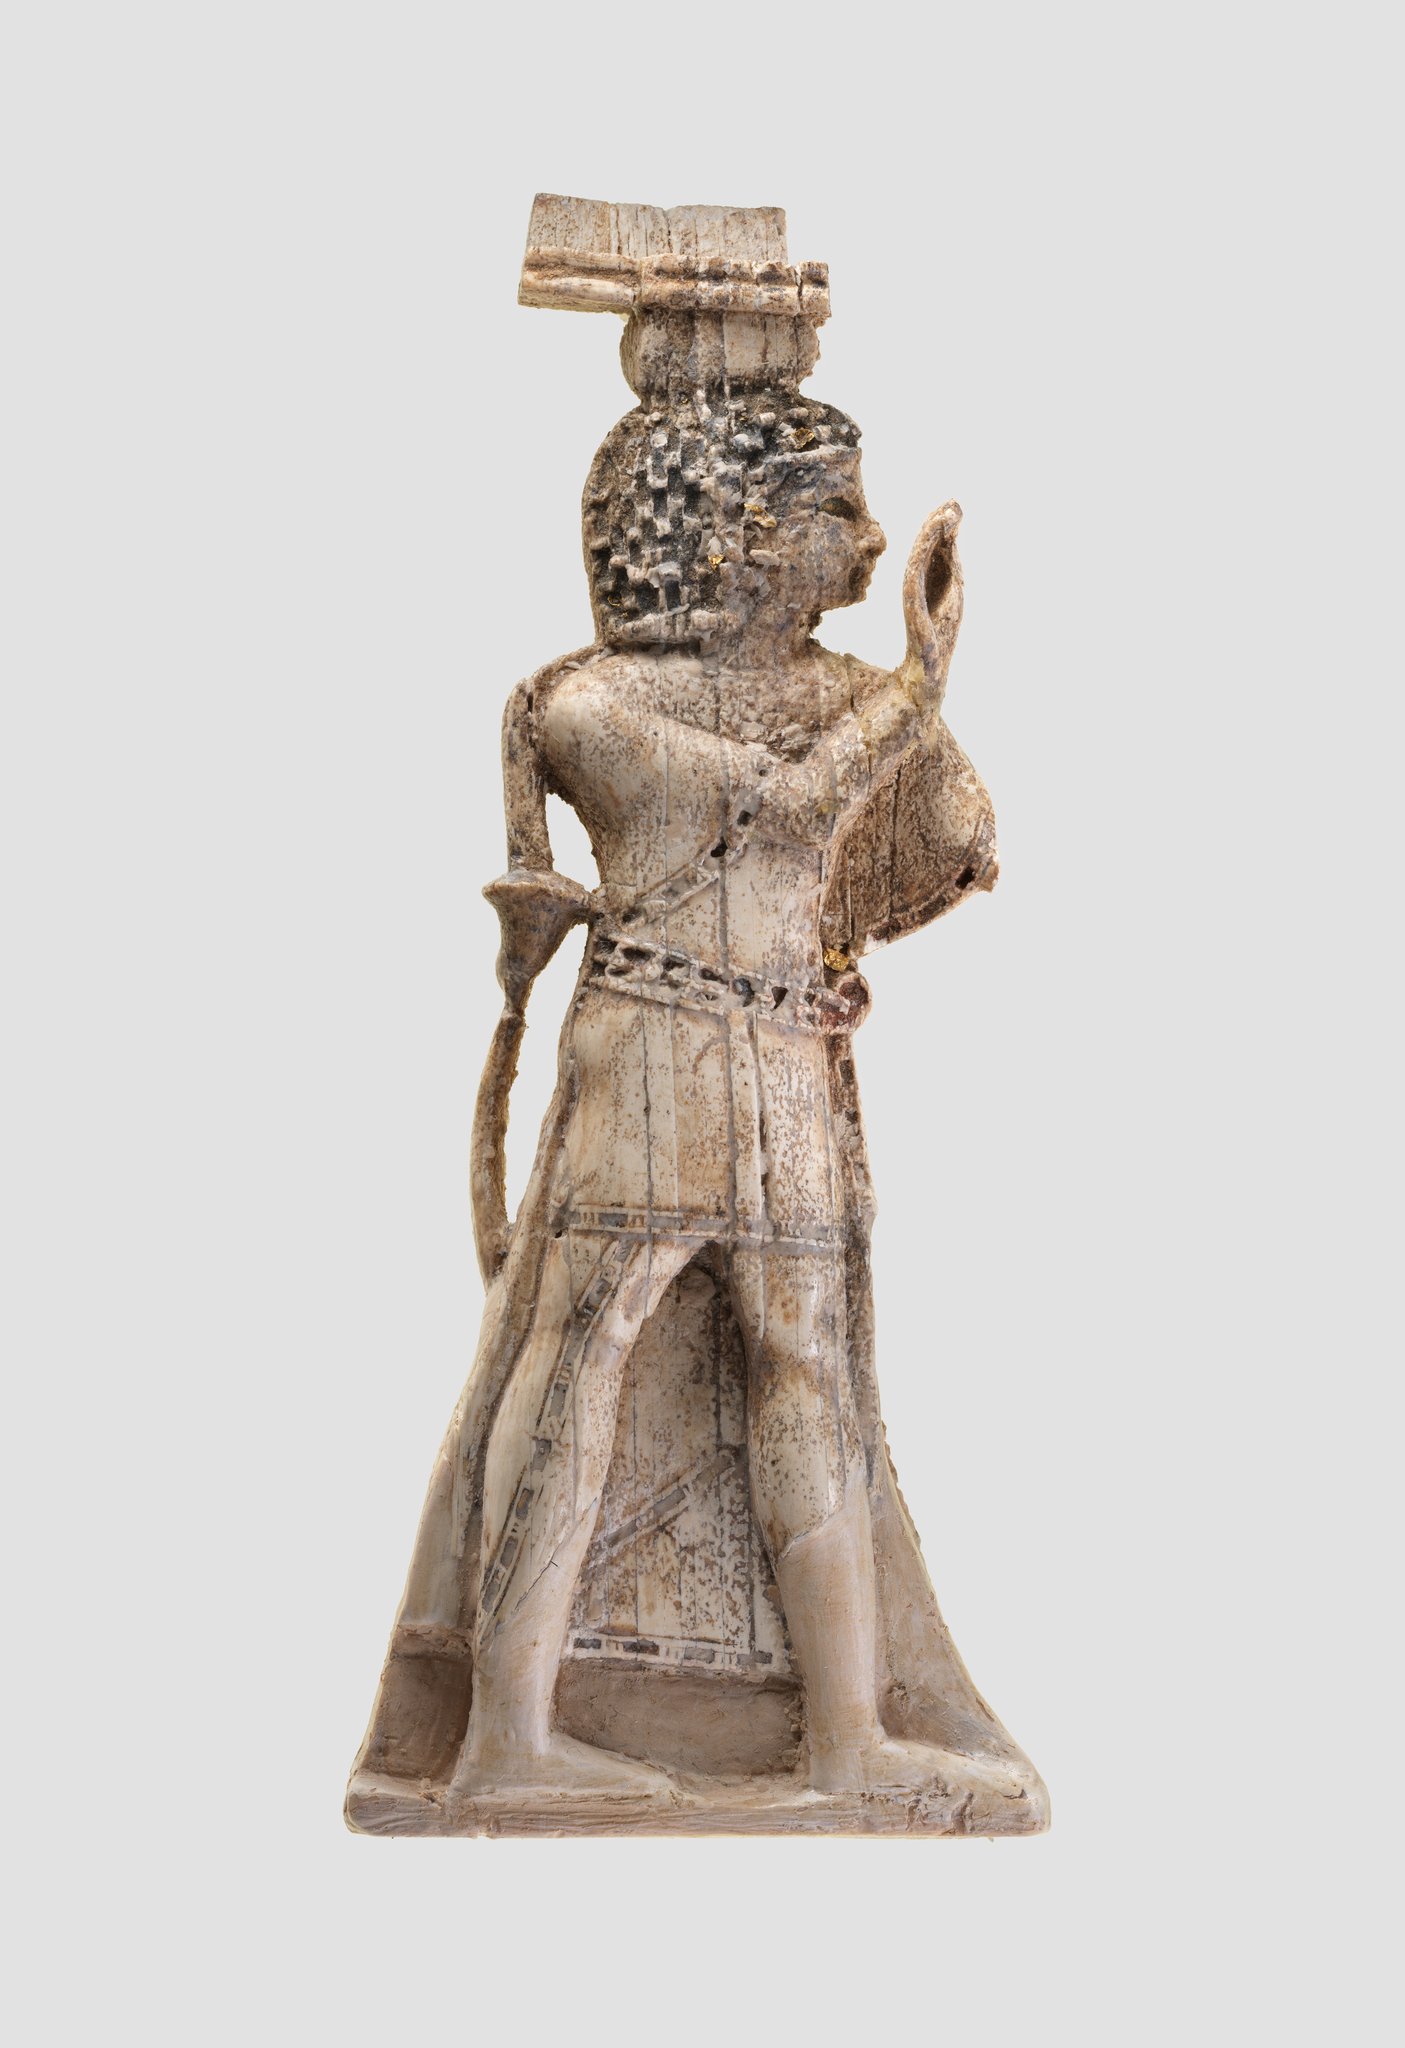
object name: relief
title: Openwork furniture plaque with a male youth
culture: assyrian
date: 800-601 BCE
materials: gold, ivory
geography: mesopotamia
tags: men